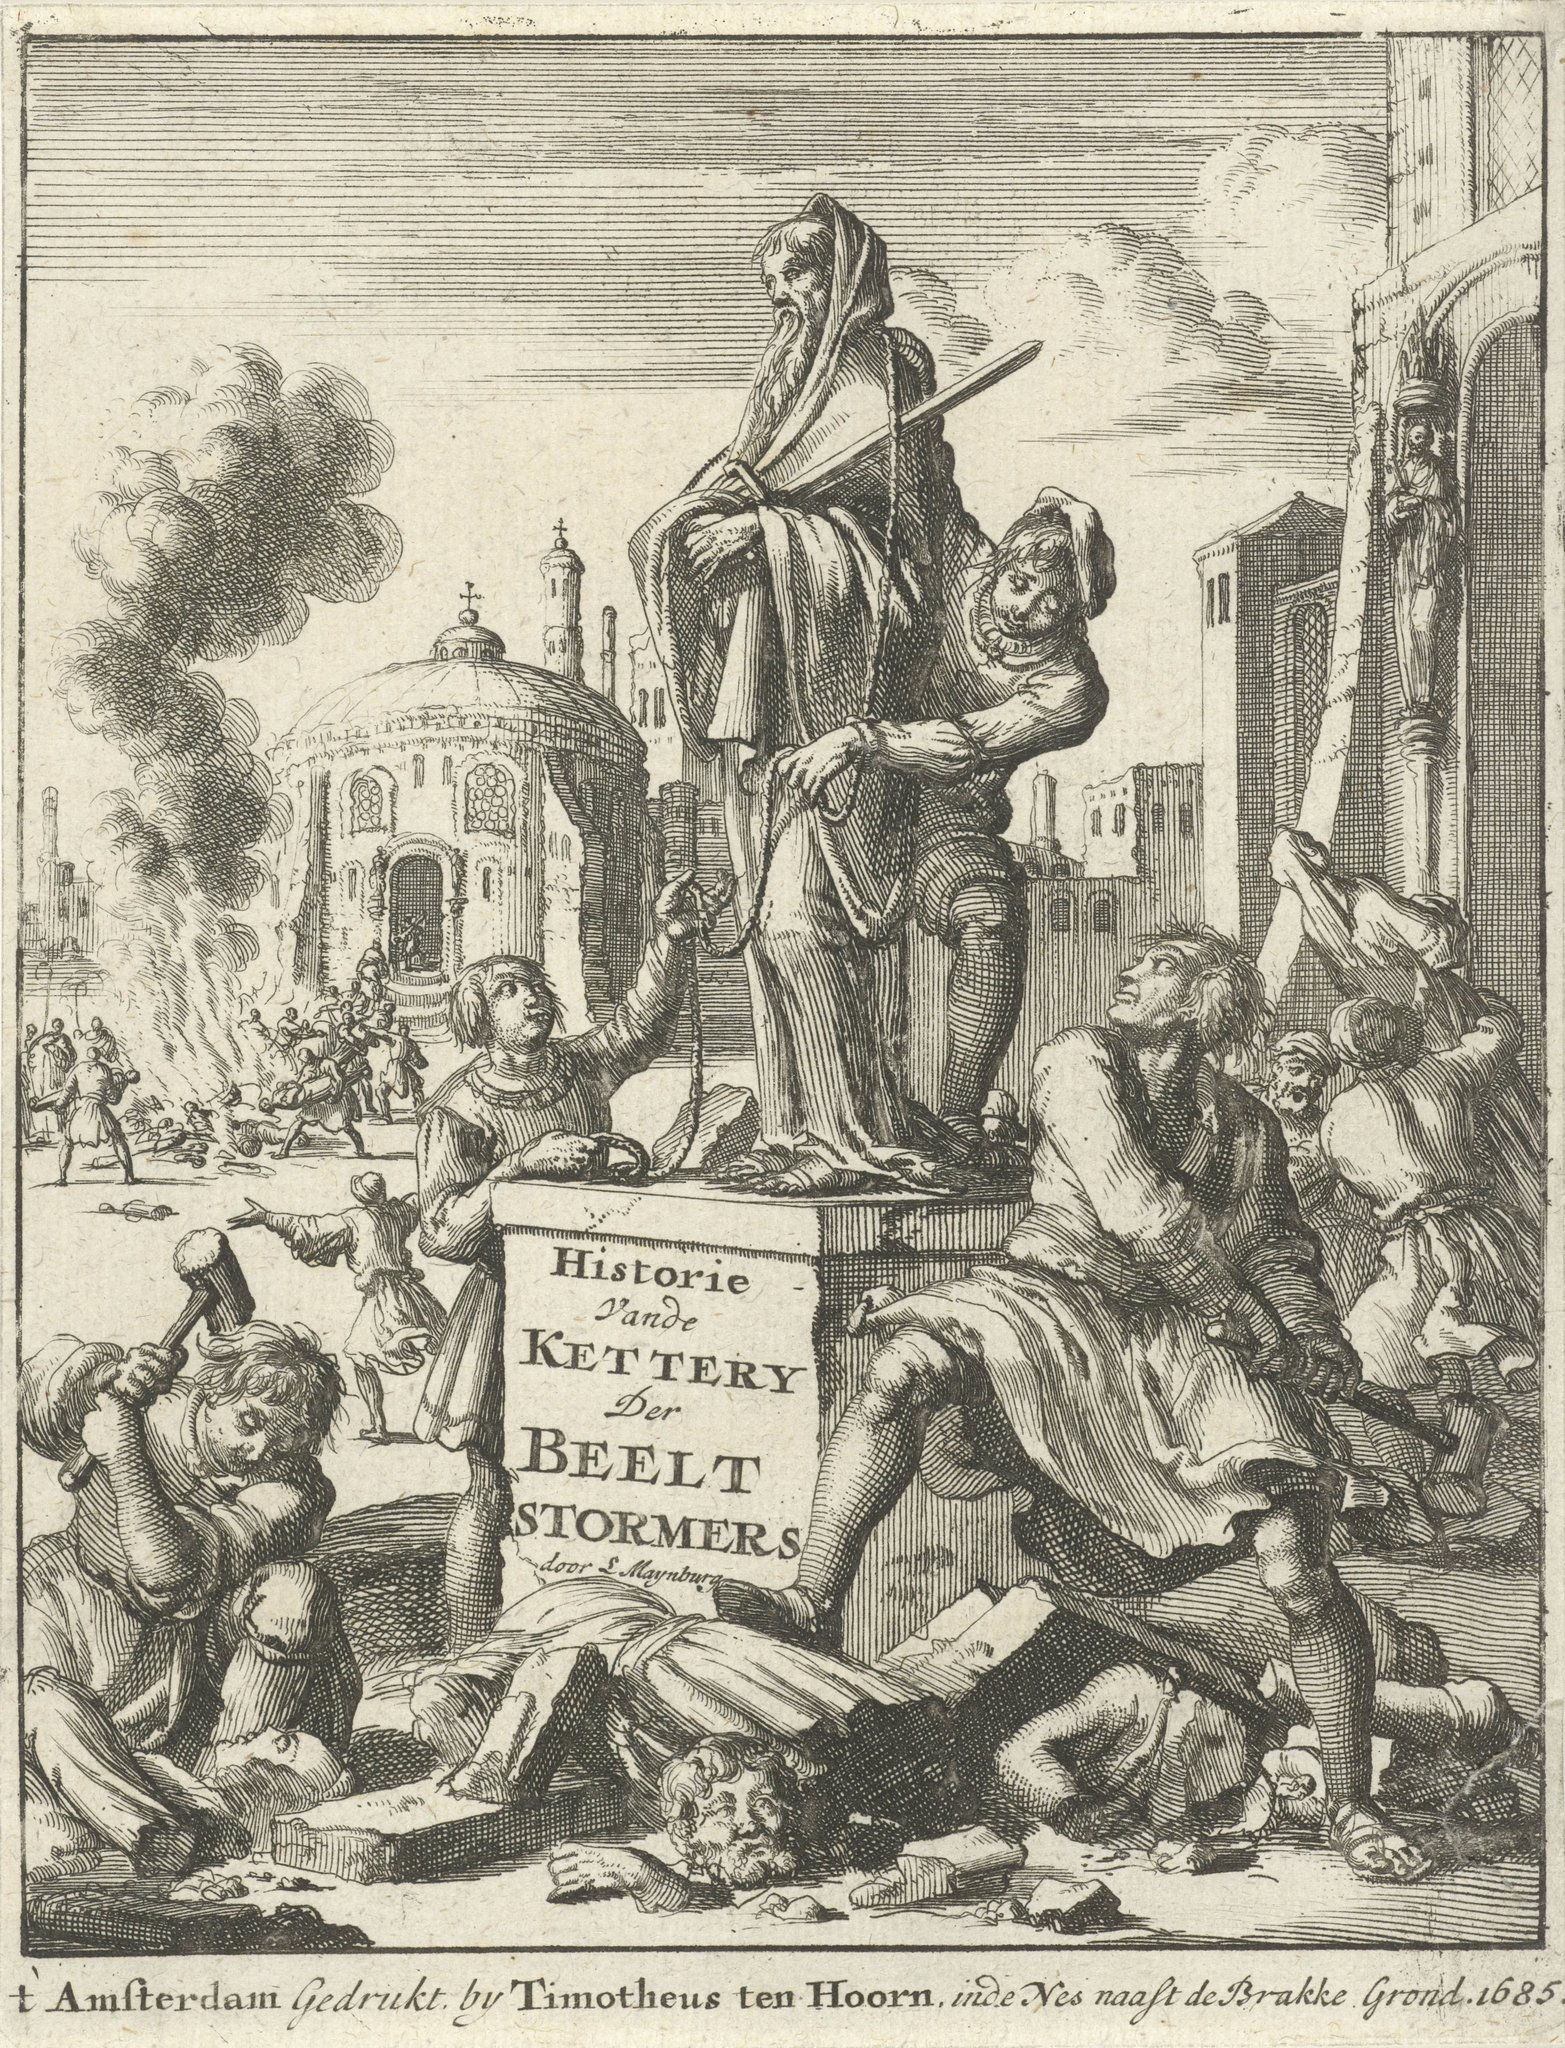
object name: print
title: Titelpagina voor: L. Maimbourg, Historie van de kettery der beeldstormers, 1685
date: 1685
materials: paper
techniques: etching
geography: amsterdam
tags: iconoclasm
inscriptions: collector's mark: Lugt 2228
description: Titelpagina voor: Maimbourg, Louis. Historie van de kettery der beeldstormers. Amsterdam: Timotheus ten Hoorn, 1685.